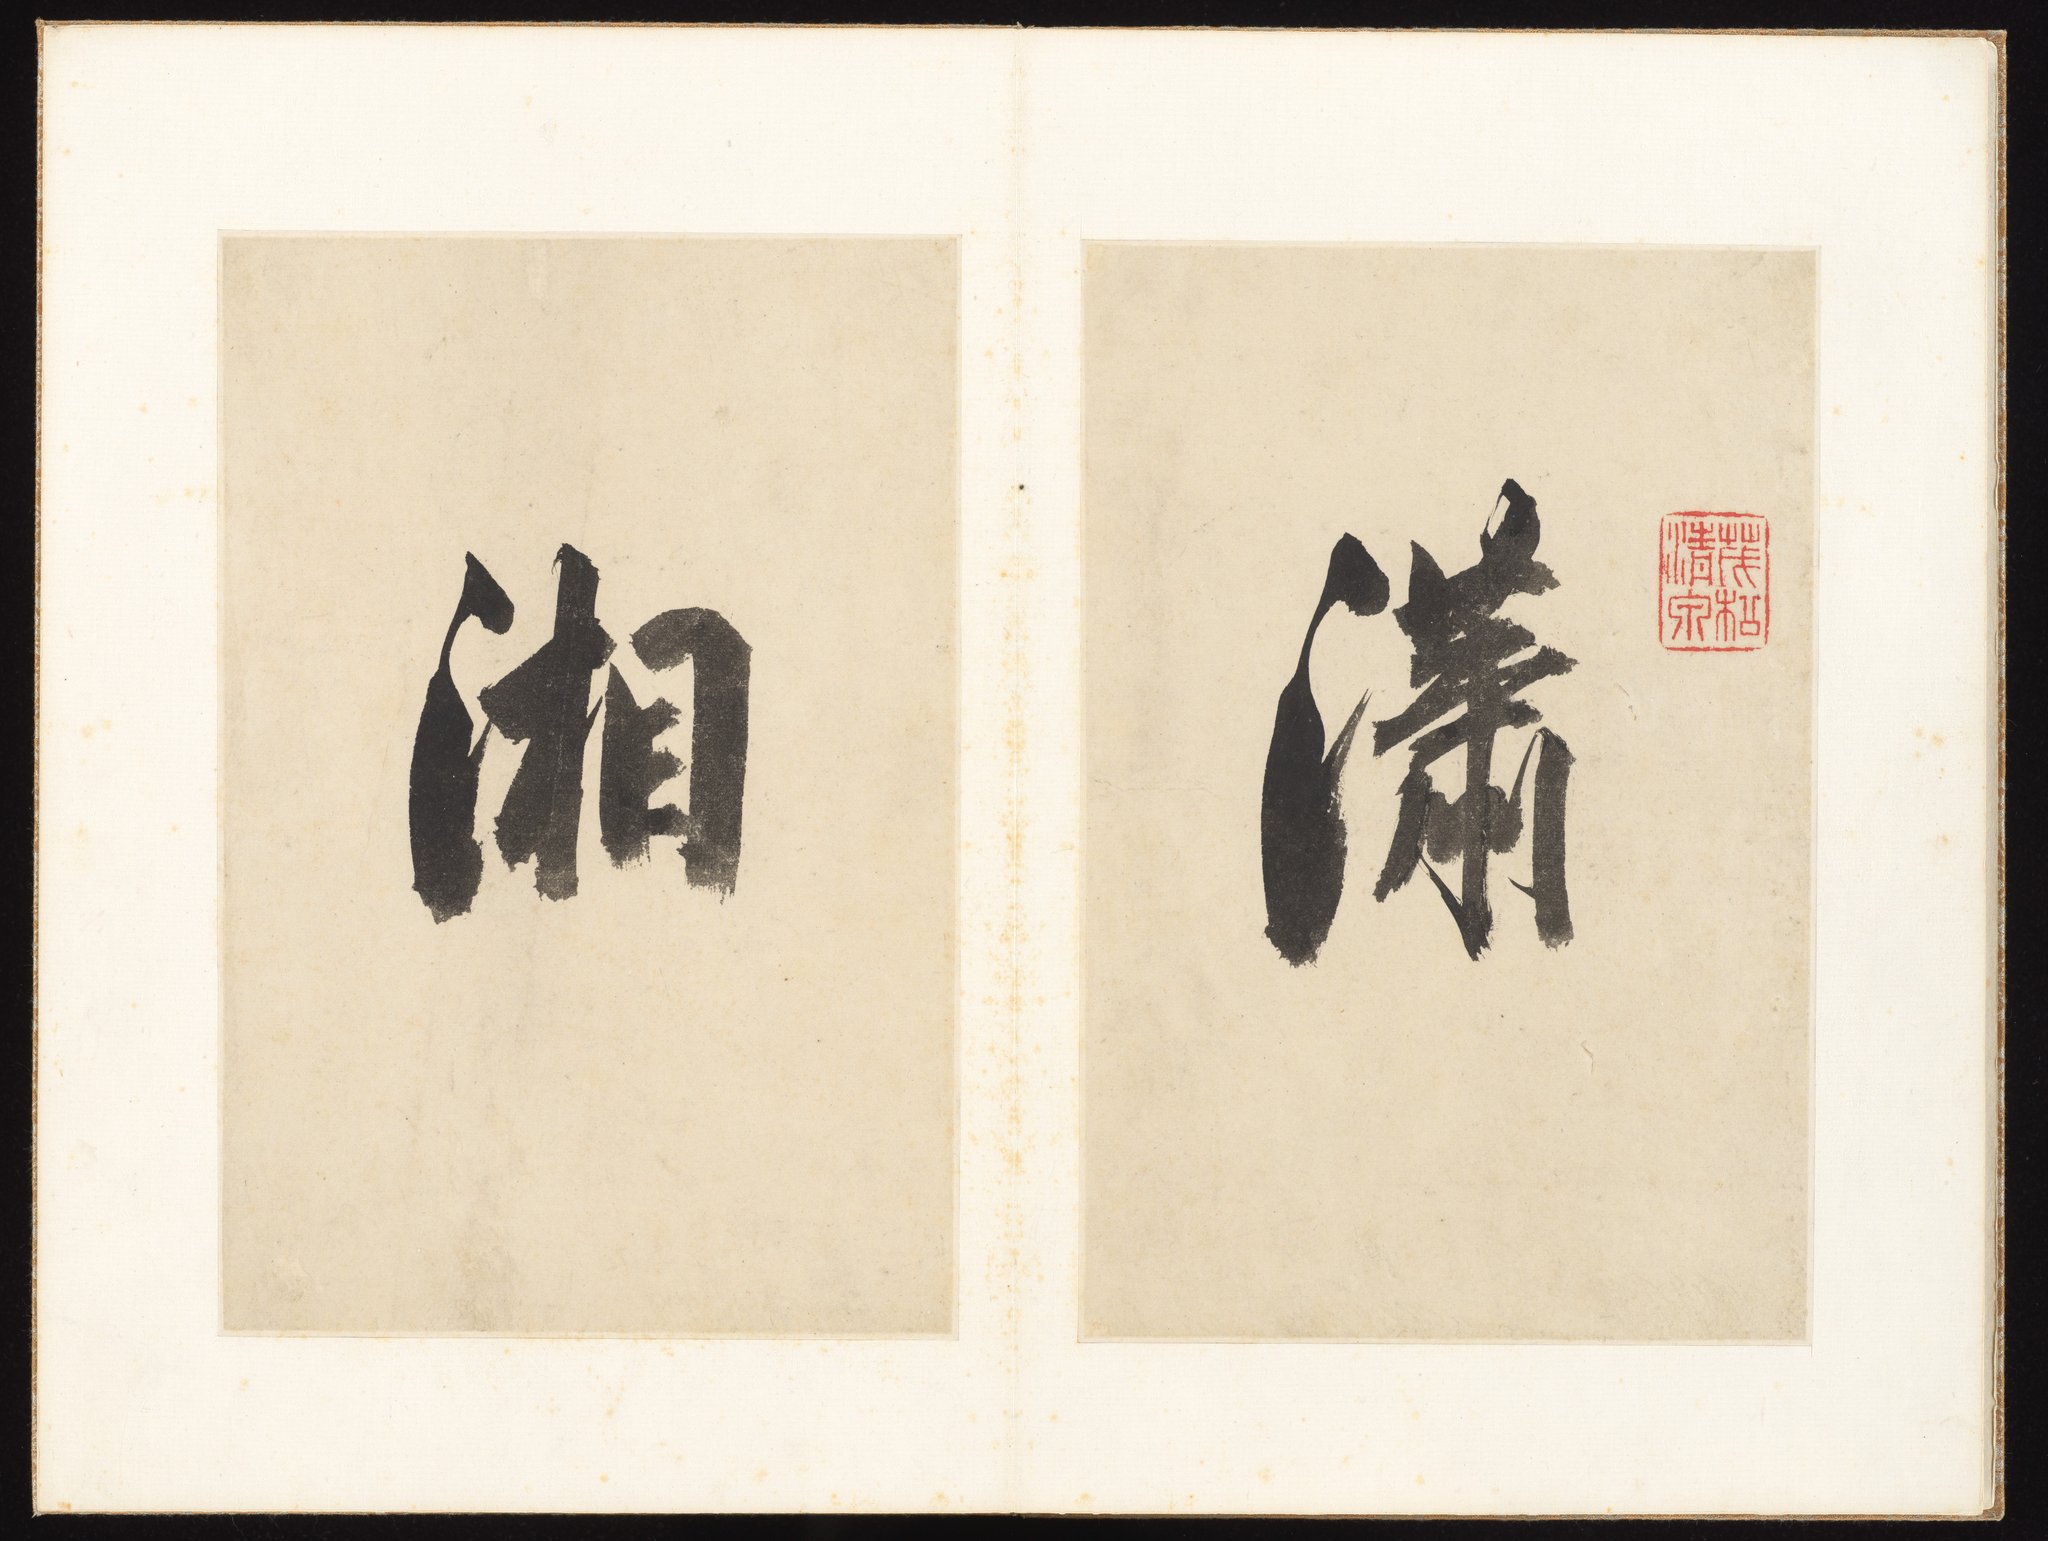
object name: album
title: Eight Views of Xiao and Xiang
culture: chinese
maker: pan simu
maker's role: artist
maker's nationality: chinese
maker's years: 1756-1842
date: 1835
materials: ink, paper